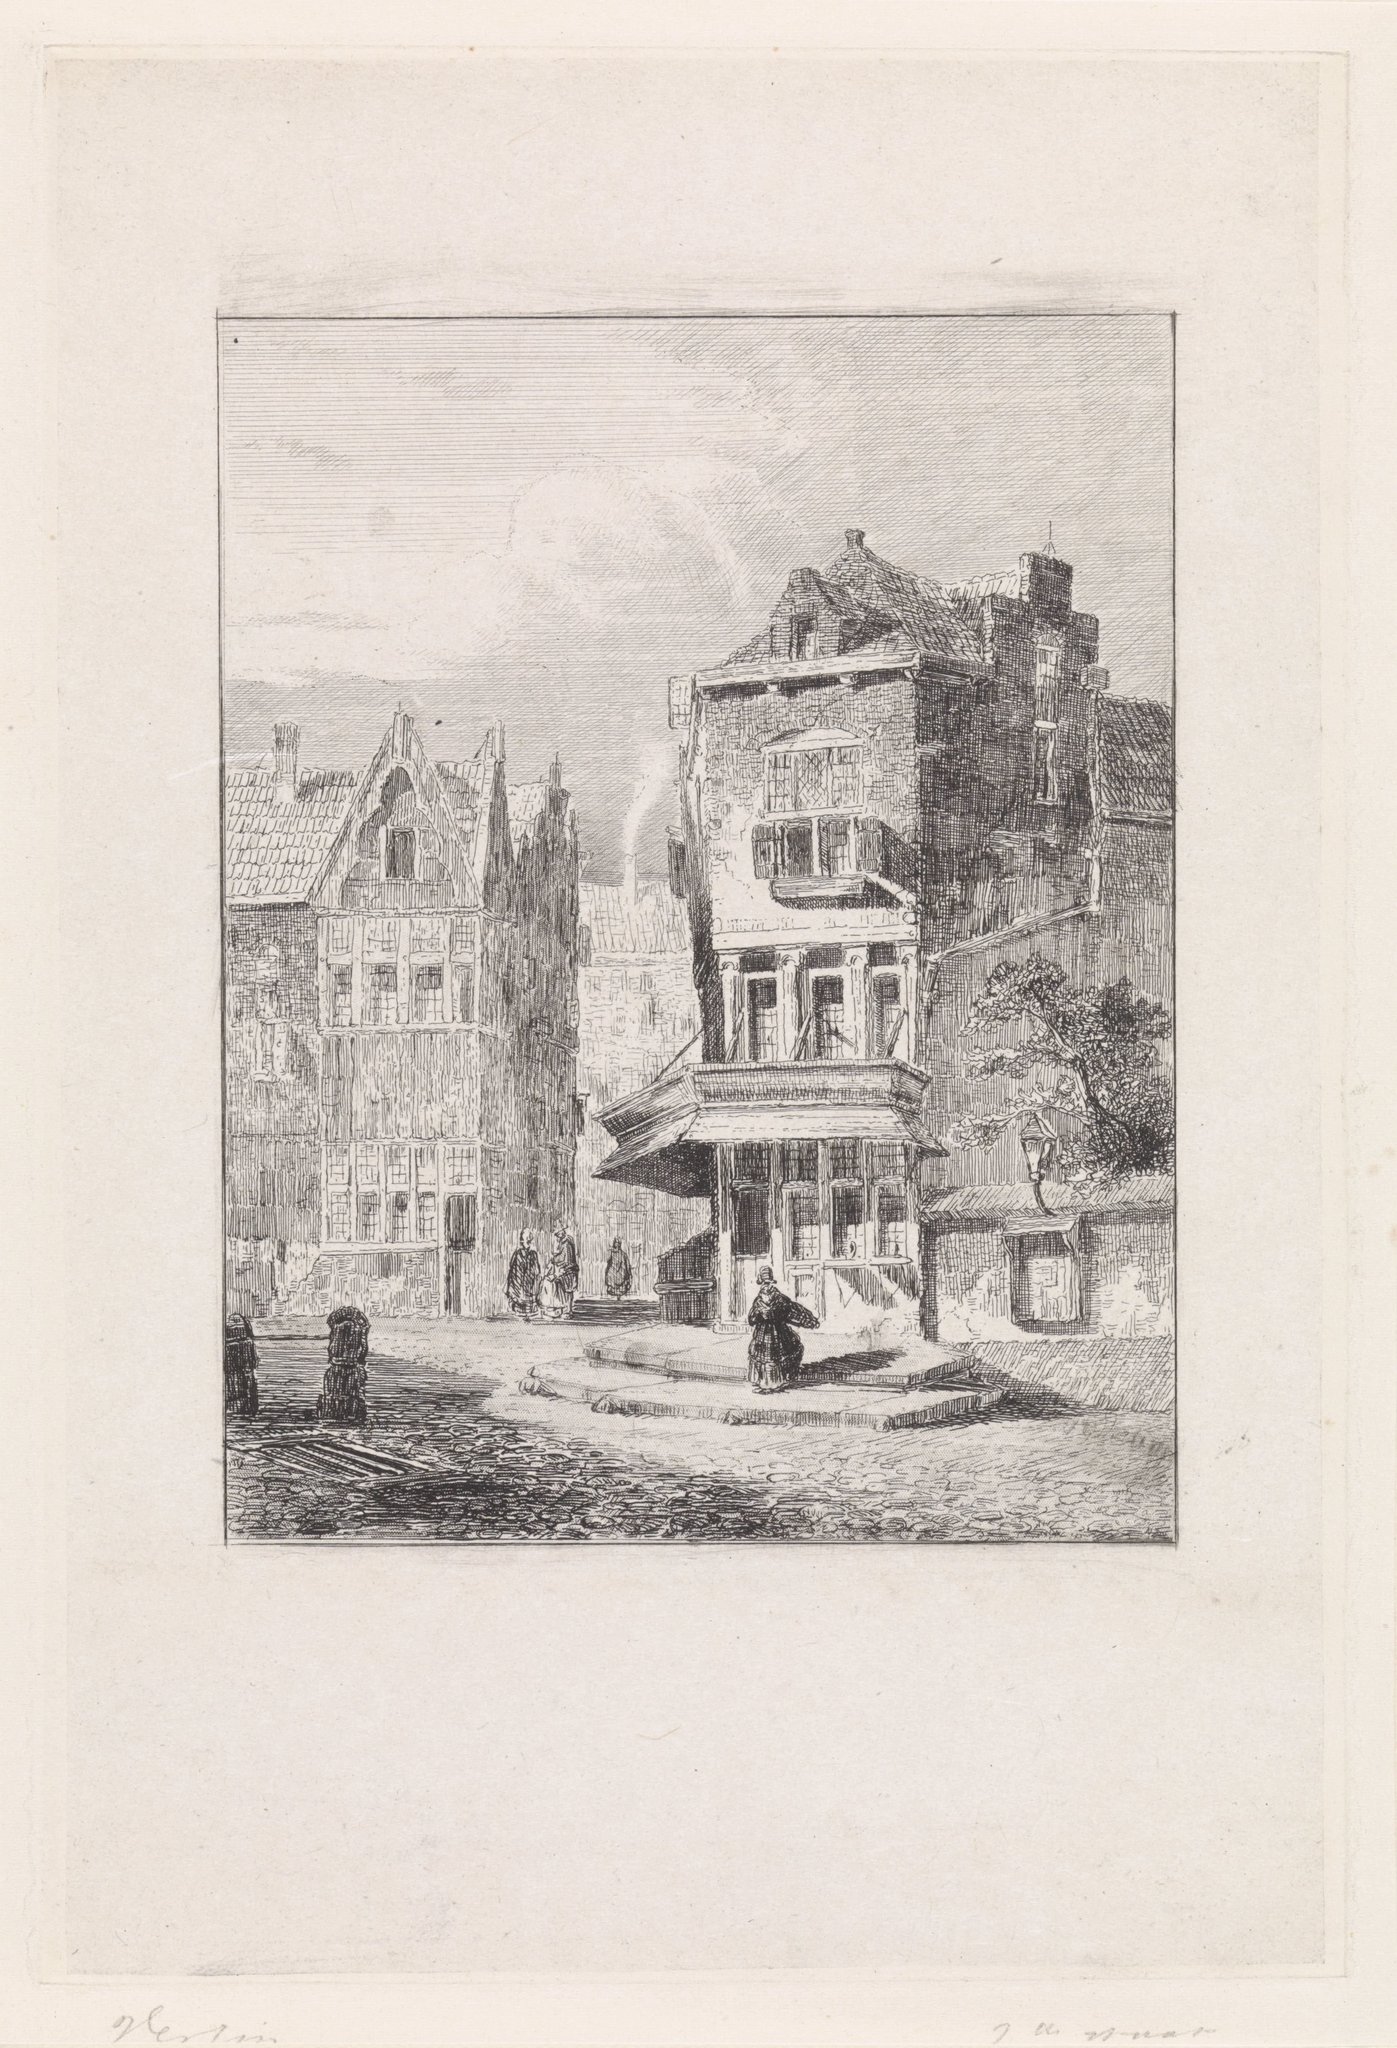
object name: print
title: Stadsgezicht met figuren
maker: petrus gerardus vertin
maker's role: draughtsman, painter, print maker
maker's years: 1819-1893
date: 1829-1890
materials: paper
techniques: etching, roulette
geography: the hague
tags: public road (+ city(-scape) with figures, staffage)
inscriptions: collector's mark: Lugt 2228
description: Stadsgezicht met in het midden een huis met een luifel, waar een vrouw de stoep op gaat. Rechts tegen een schuur een aanplakbord, waarboven een lantaarn. In het midden op de achtergrond een straat.